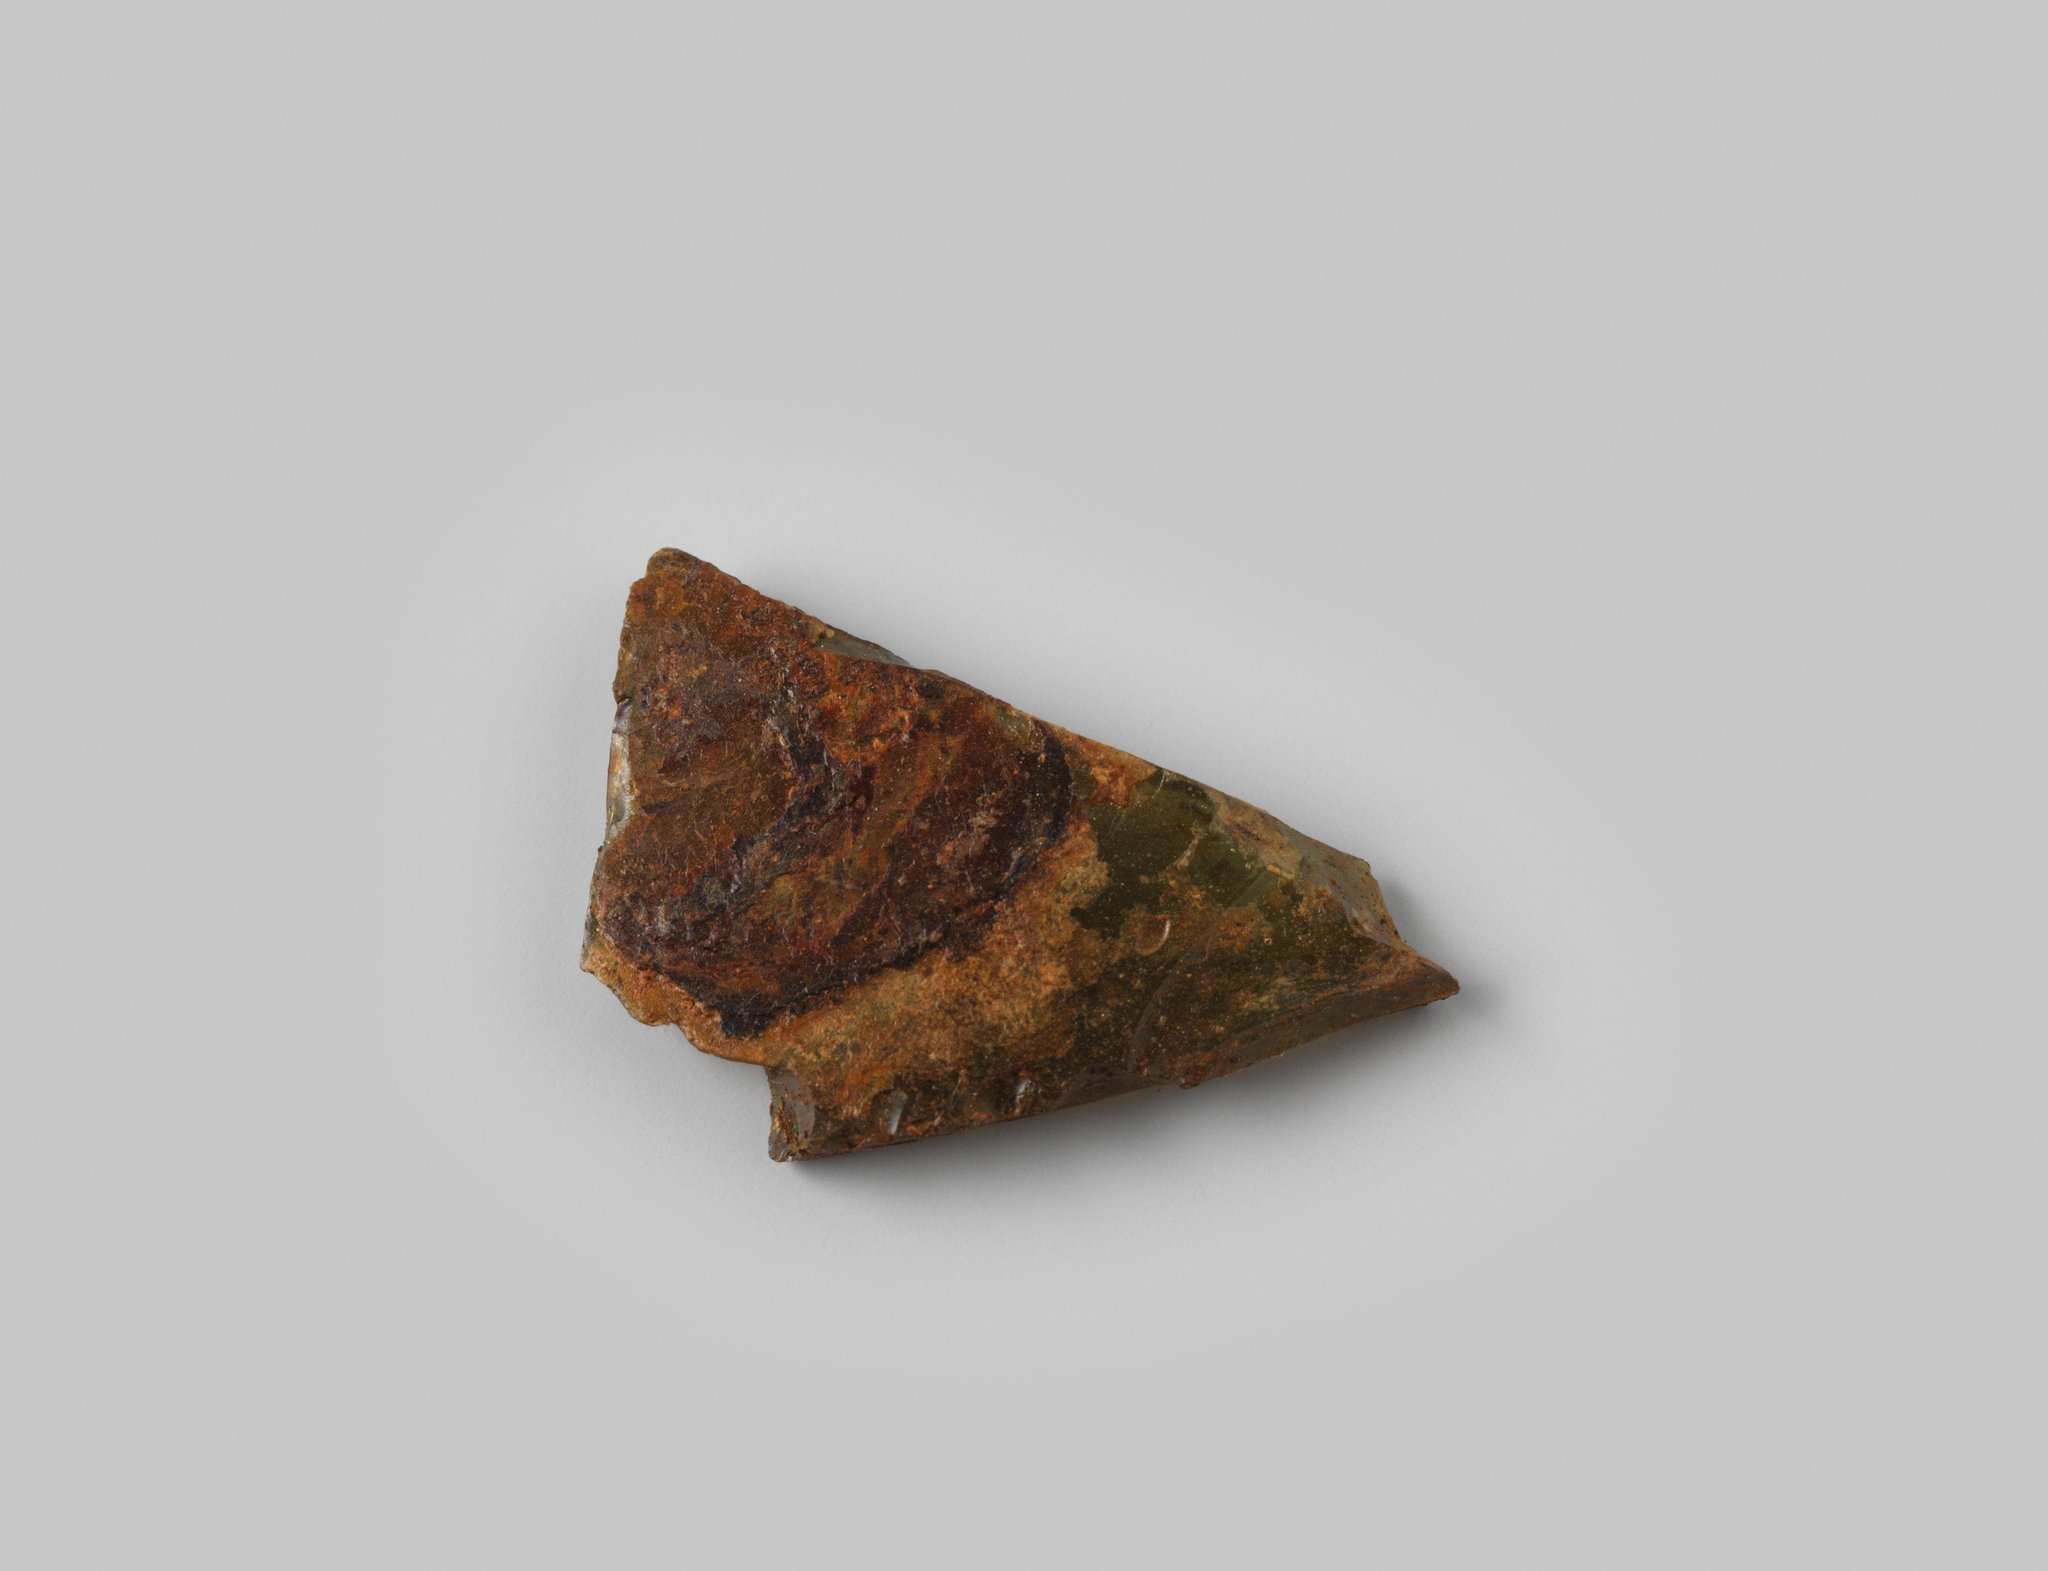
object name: sherd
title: Scherf van een wijnfles uit het wrak van de Oost-Indiëvaarder Hollandia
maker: Anonymous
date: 1700-1743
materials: glass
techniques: green glass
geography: netherlands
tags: verenigde oostindische compagnie, hollandia (schip), annet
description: Typologically not identifiable, belly, fragment.